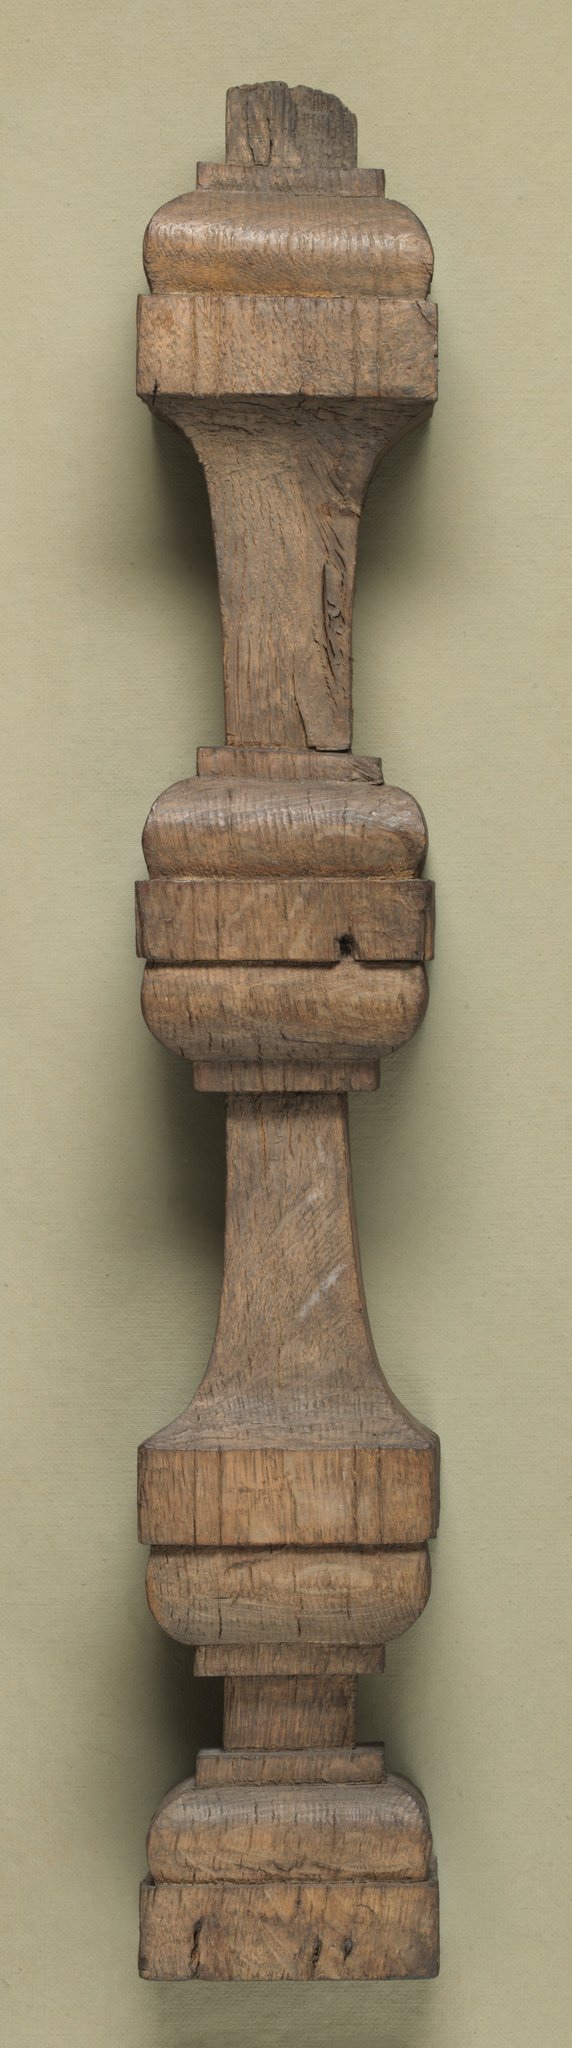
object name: baluster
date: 1501-1600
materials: wood